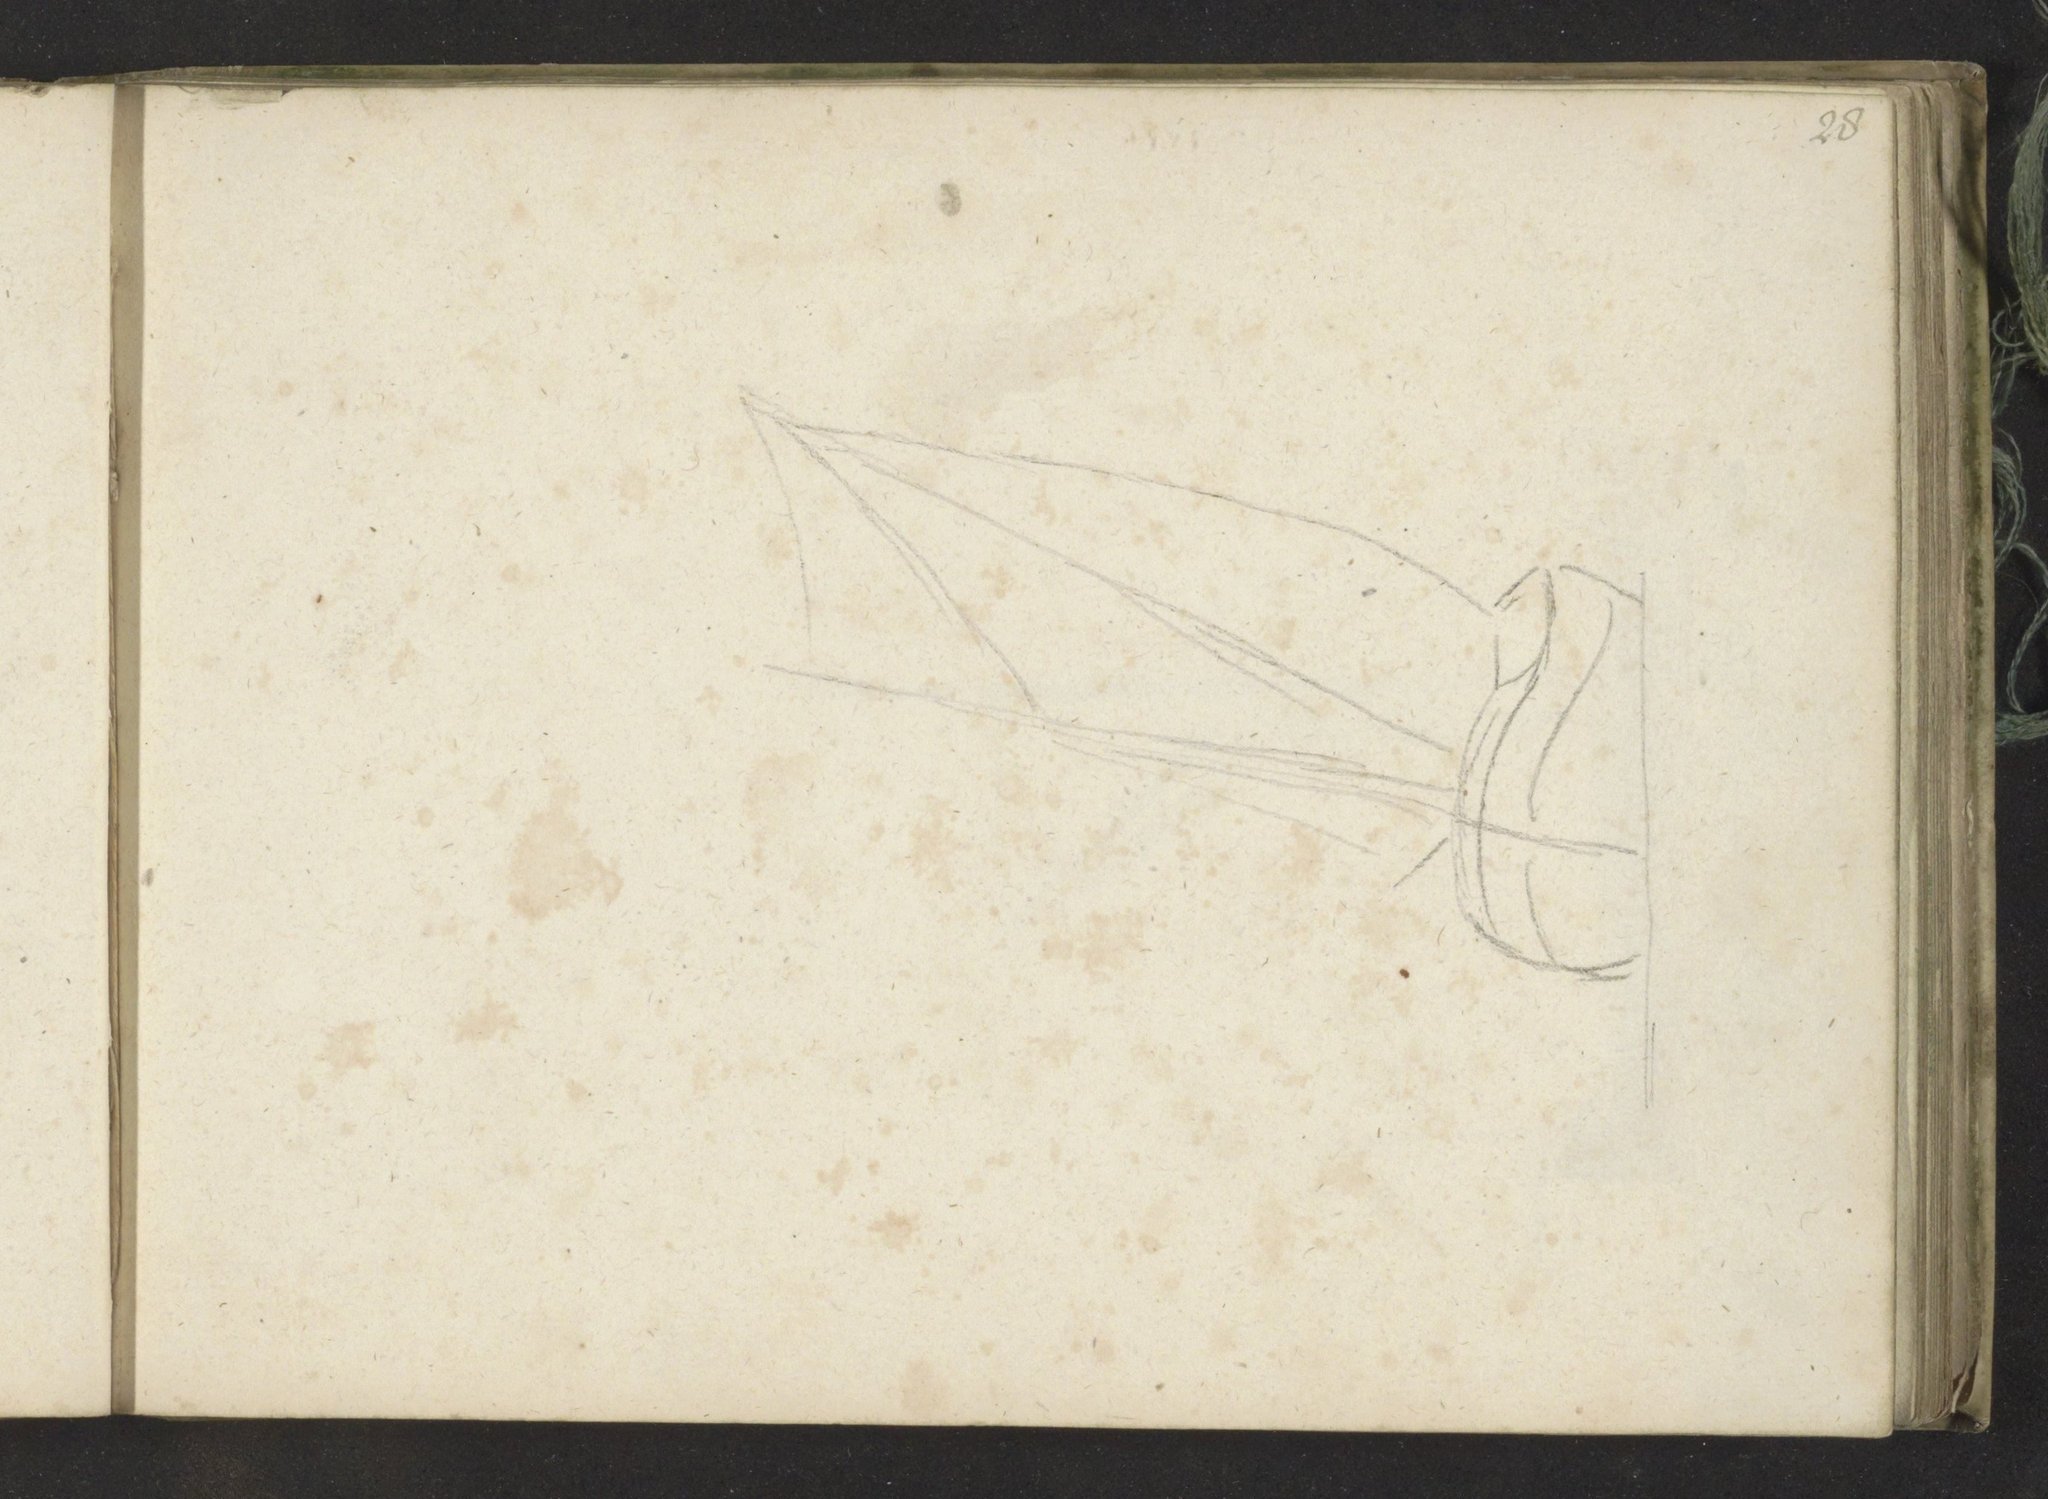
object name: sketchbook leaf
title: Zeilschip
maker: martinus schouman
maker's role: draughtsman, painter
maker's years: 1770-1848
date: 1780-1848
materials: paper, pencil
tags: sailing-ship, sailing-boat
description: Blad 28 recto uit een schetsboek met 53 bladen.